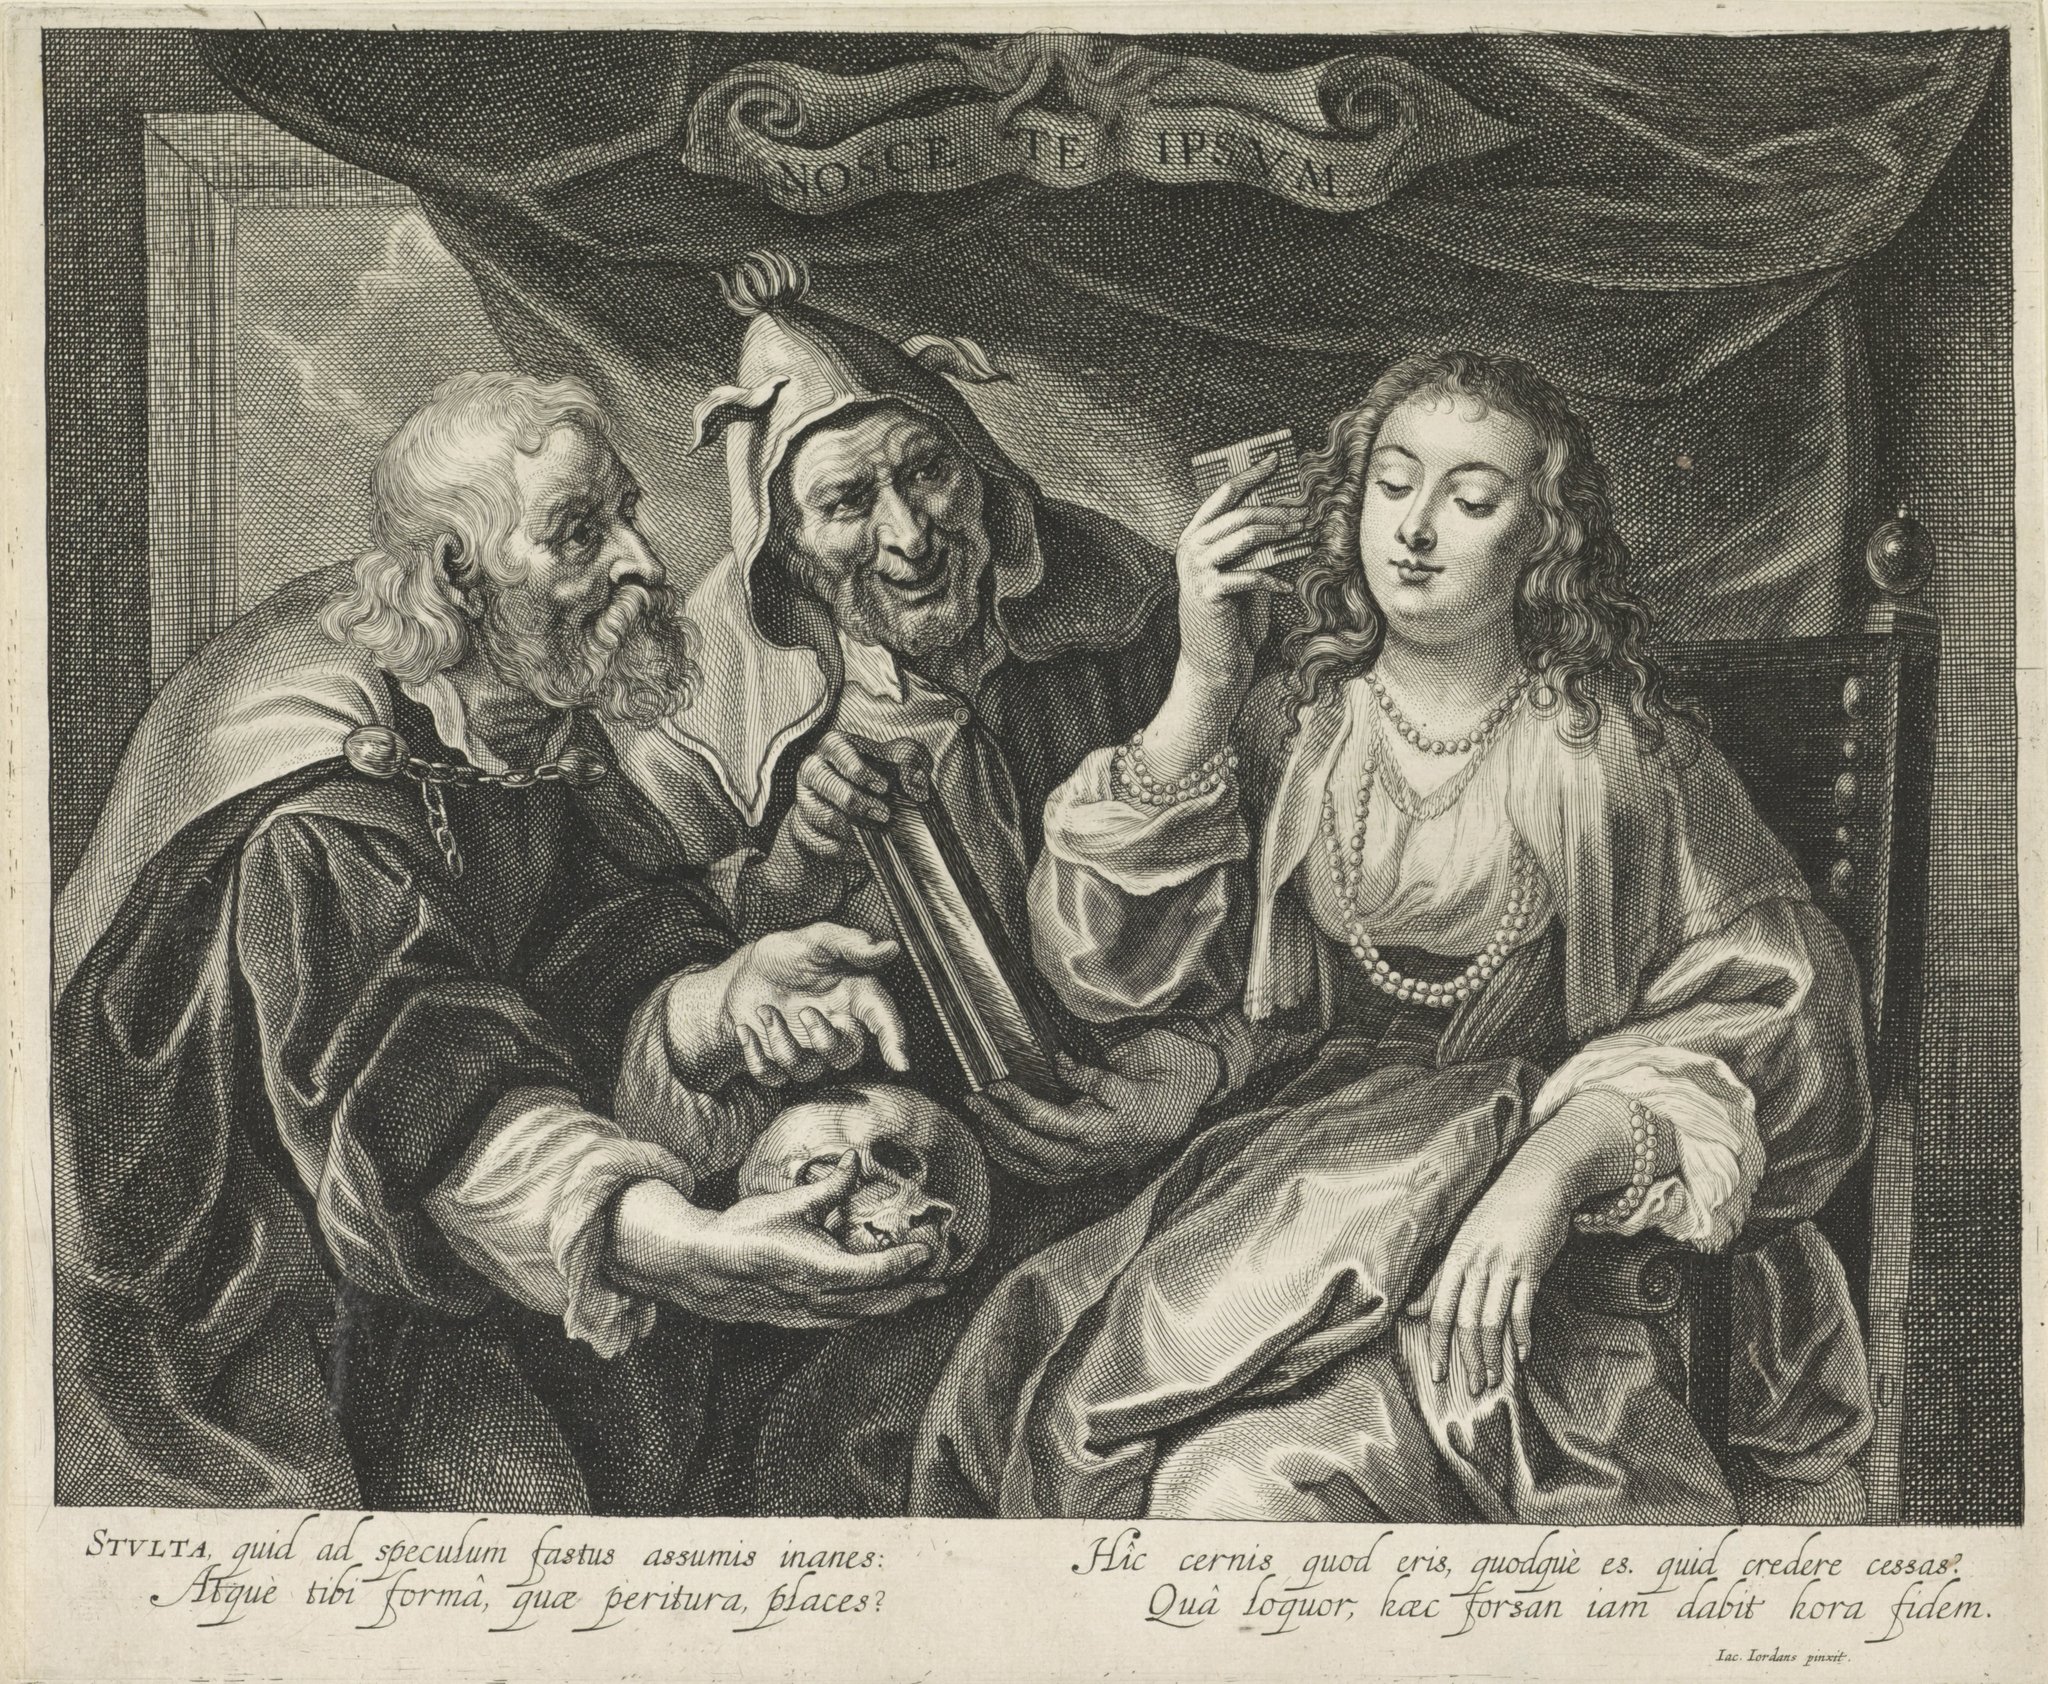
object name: print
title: Nosce te Ipsvm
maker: jacques jordaens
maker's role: designer, draughtsman, painter, print maker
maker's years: 1593-1678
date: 1661-1695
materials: paper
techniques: engraving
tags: comb, brush and other tools (care of the hair) - aa - ~ women, skull as symbol of 'vanitas', (woman) looking in a mirror ~ scene symbolizing 'vanitas', fool's cap, necklace (+ women's clothes)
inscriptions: collector's mark: Lugt 240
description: Allegorische voorstelling met een vrouw zittend in een stoel, veel parels rond haar polsen en hals, die haar haar kamt terwijl zij in de spiegel kijkt die wordt vastgehouden door een man met een narrenkap. Een tweede man waarschuwt voor ijdelheid door naar een schedel wijzen.